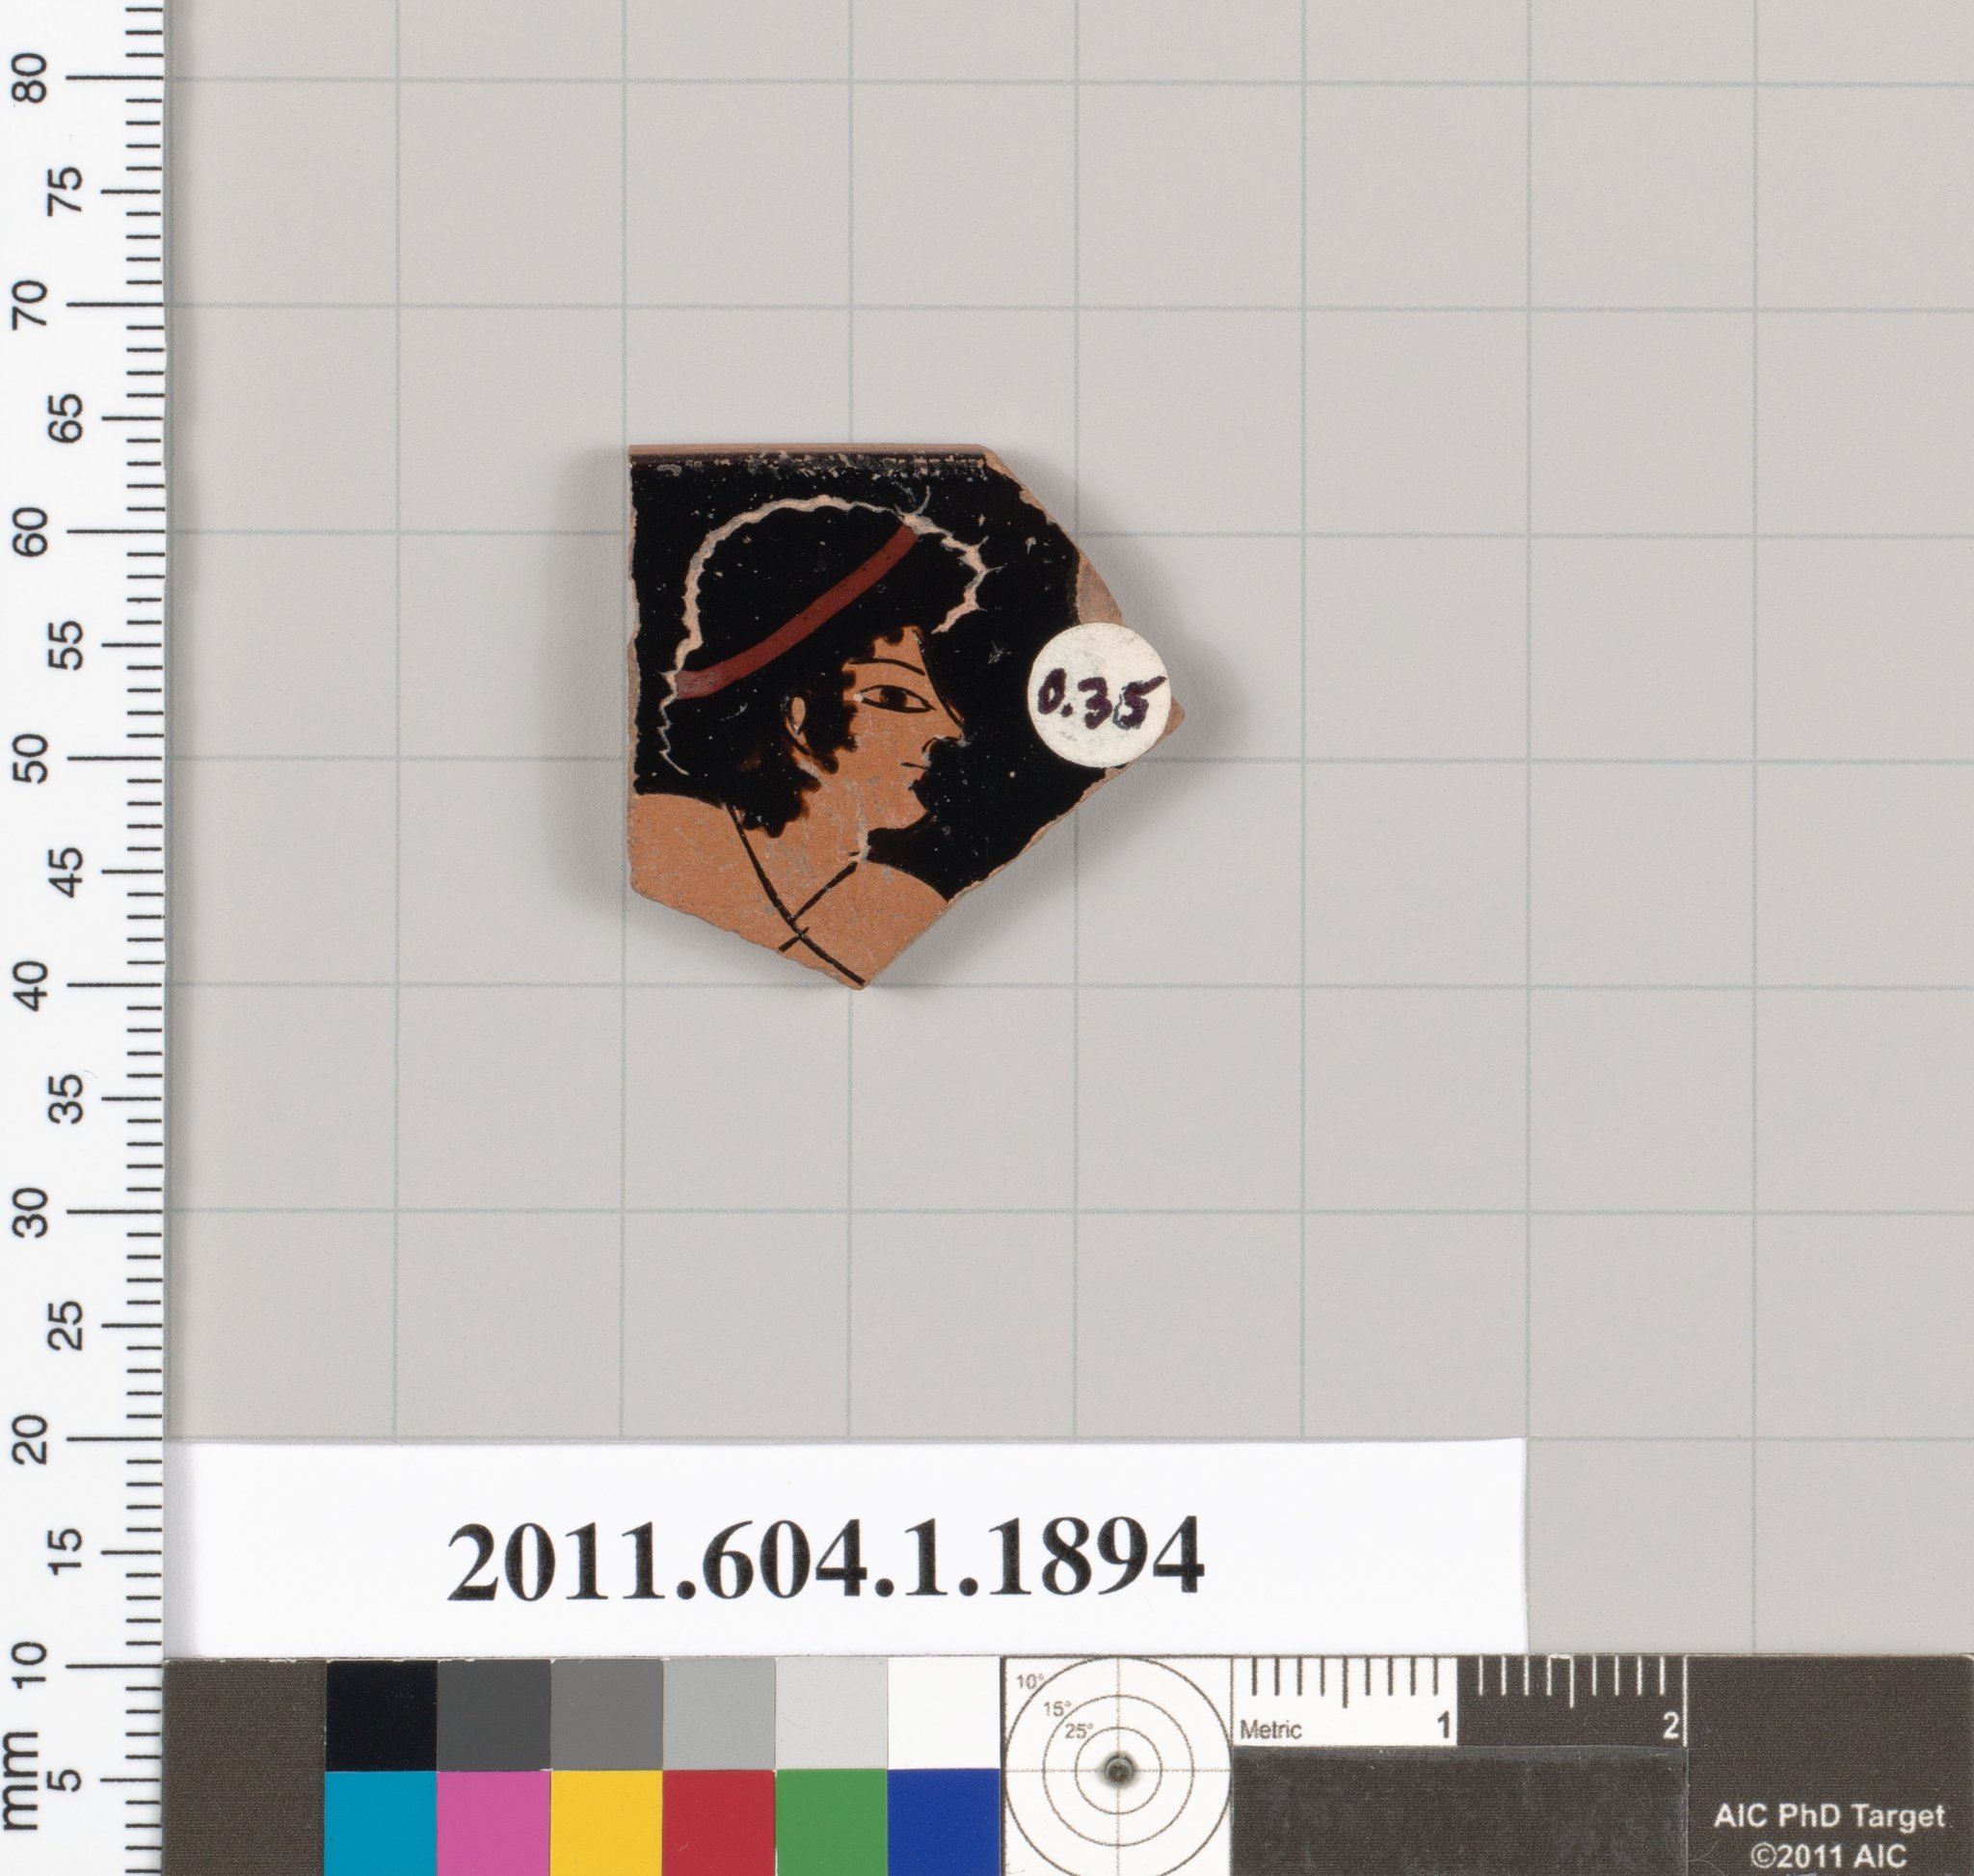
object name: kylix fragment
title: Terracotta rim fragment of a kylix (drinking cup)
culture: greek, attic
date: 520-510 BCE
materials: terracotta